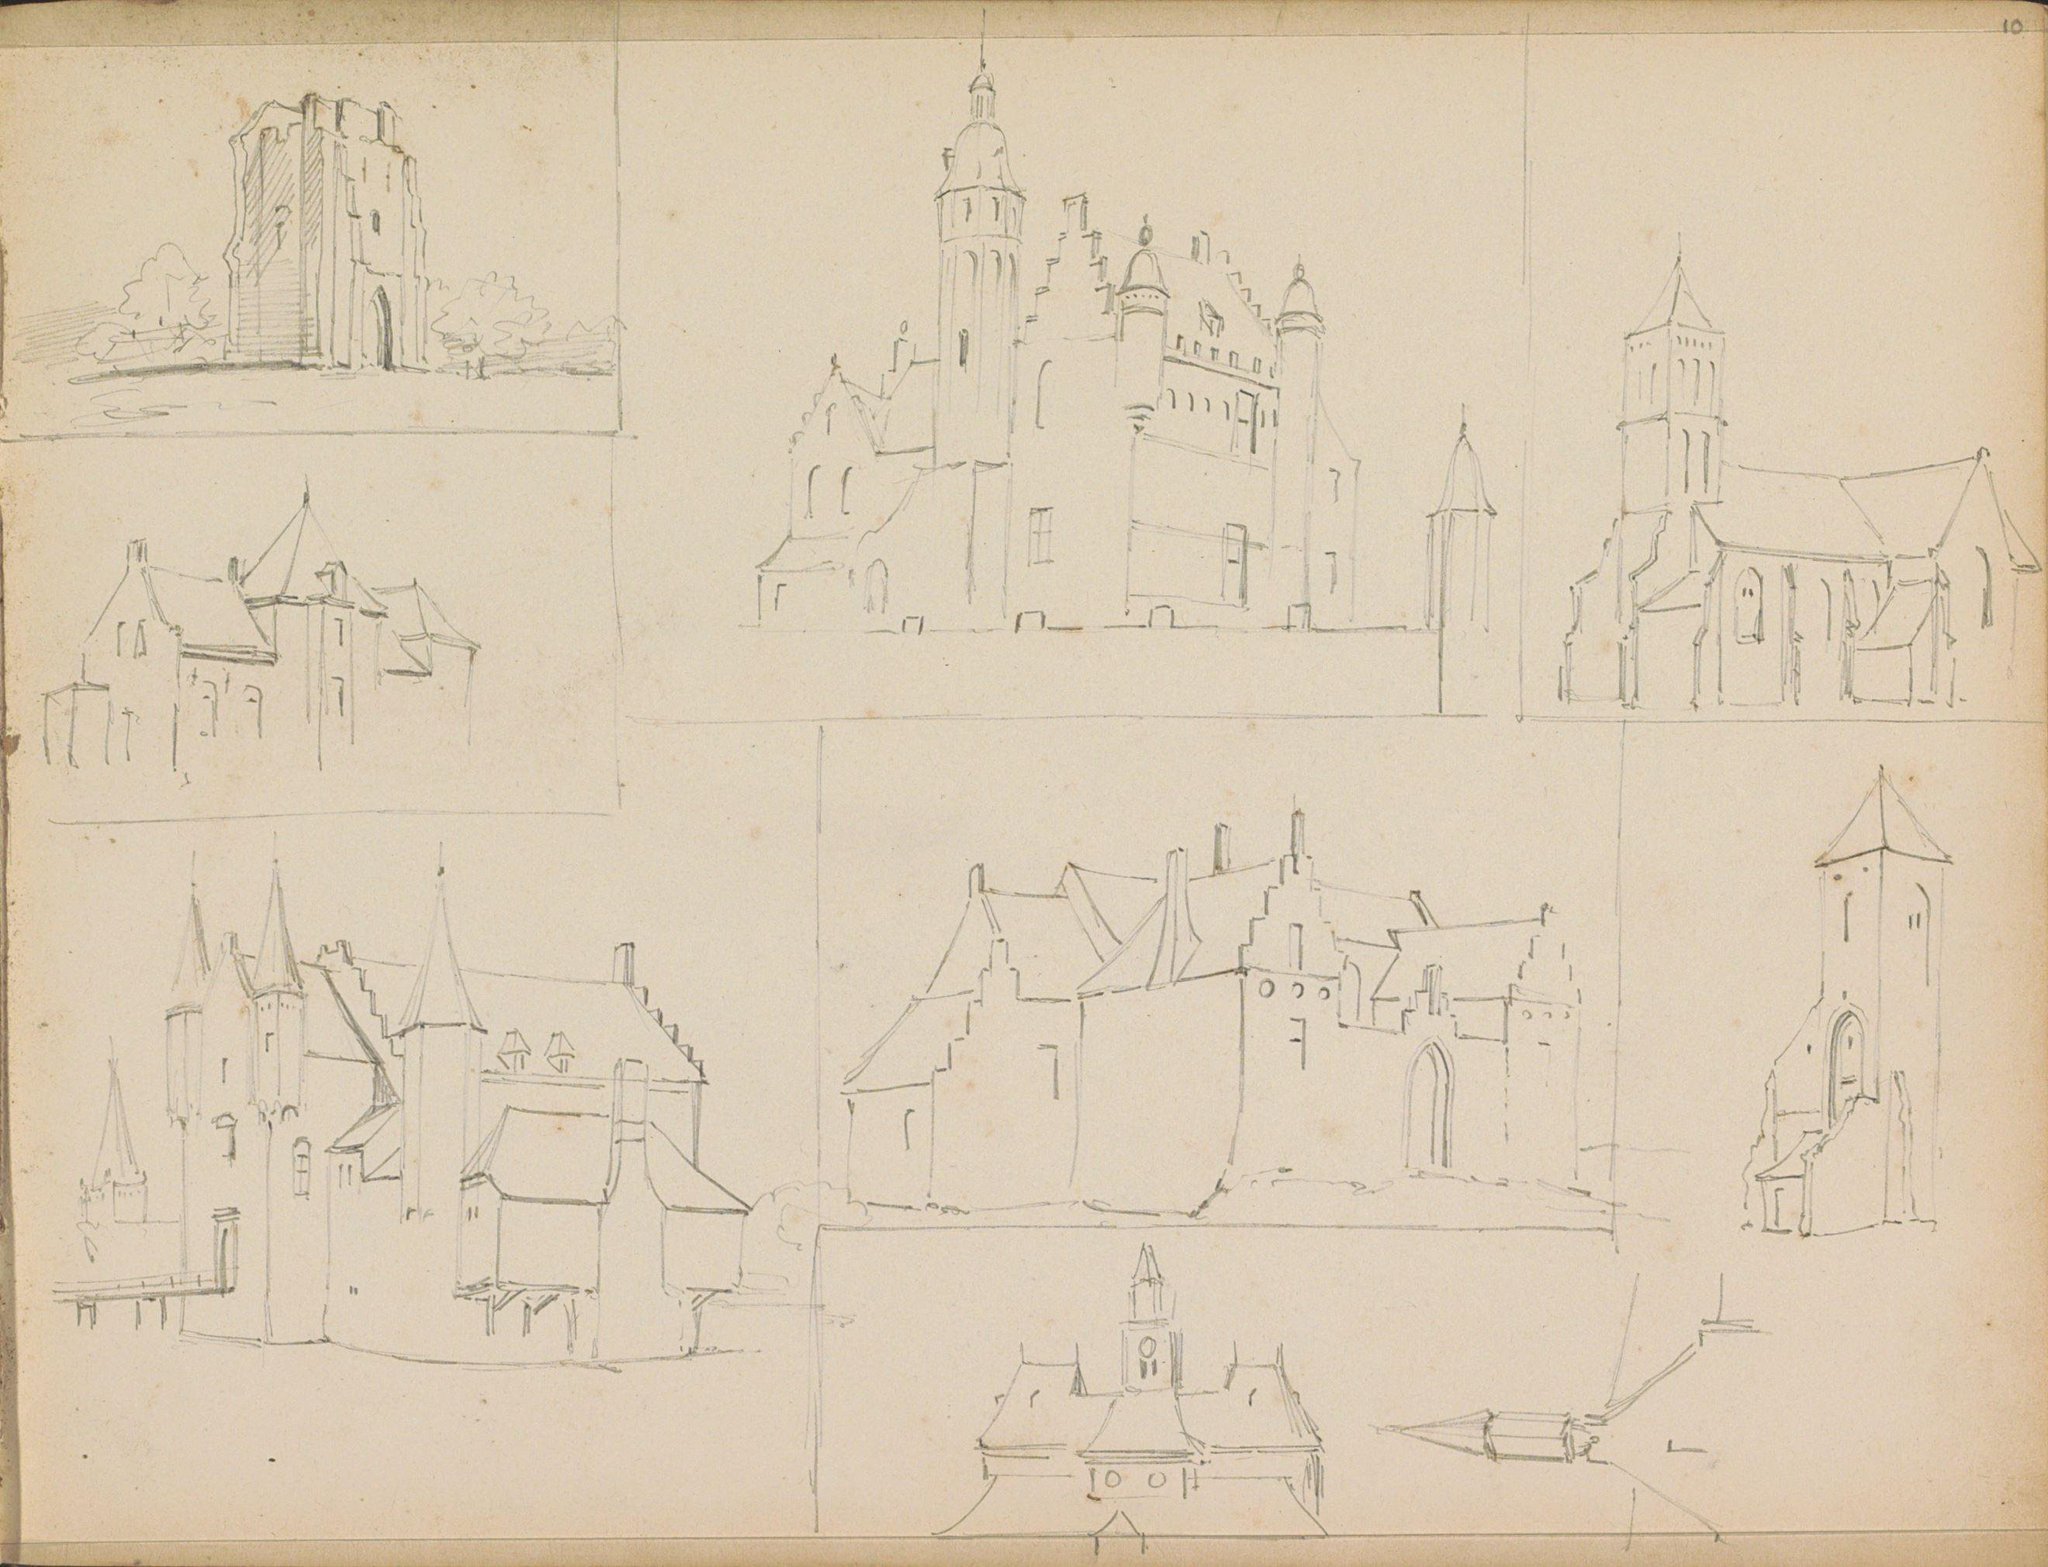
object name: sketchbook leaf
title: Studieblad met versterkte gebouwen en een kerk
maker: adrianus eversen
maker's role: draughtsman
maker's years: 1818-1897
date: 1828-1897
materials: paper, pencil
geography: netherlands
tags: castle, church (exterior)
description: Studieblad met zeven versterkte gebouwen, mogelijk kastelen. Rechtsboven een kerk en rechtsonder een dak met een toren. Blad 10 uit een schetsboek met 41 bladen.